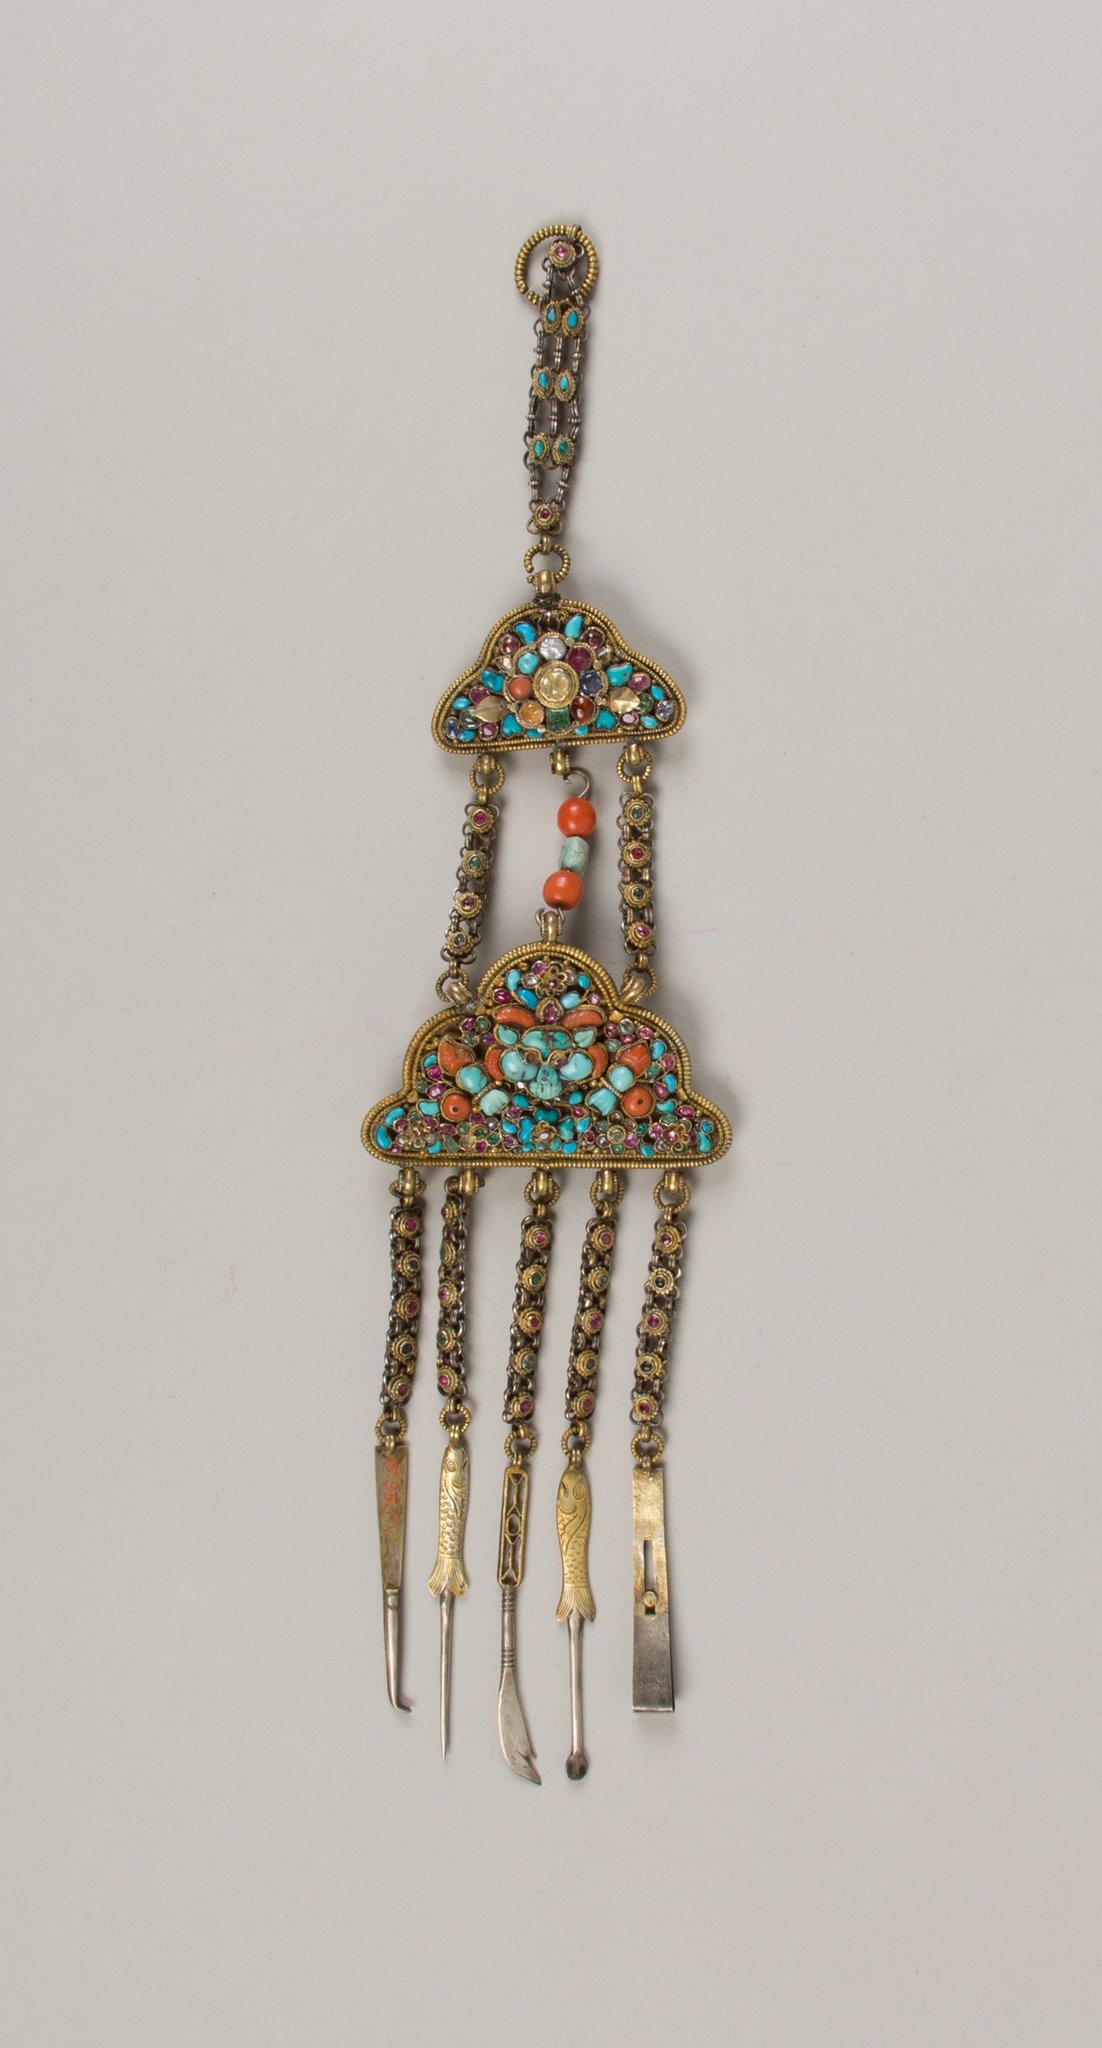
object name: belt hanging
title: Woman’s Belt Hangings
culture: newari or tibetan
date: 1601-1900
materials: coral, gemstone, silver gilt, lapis lazuli, shell